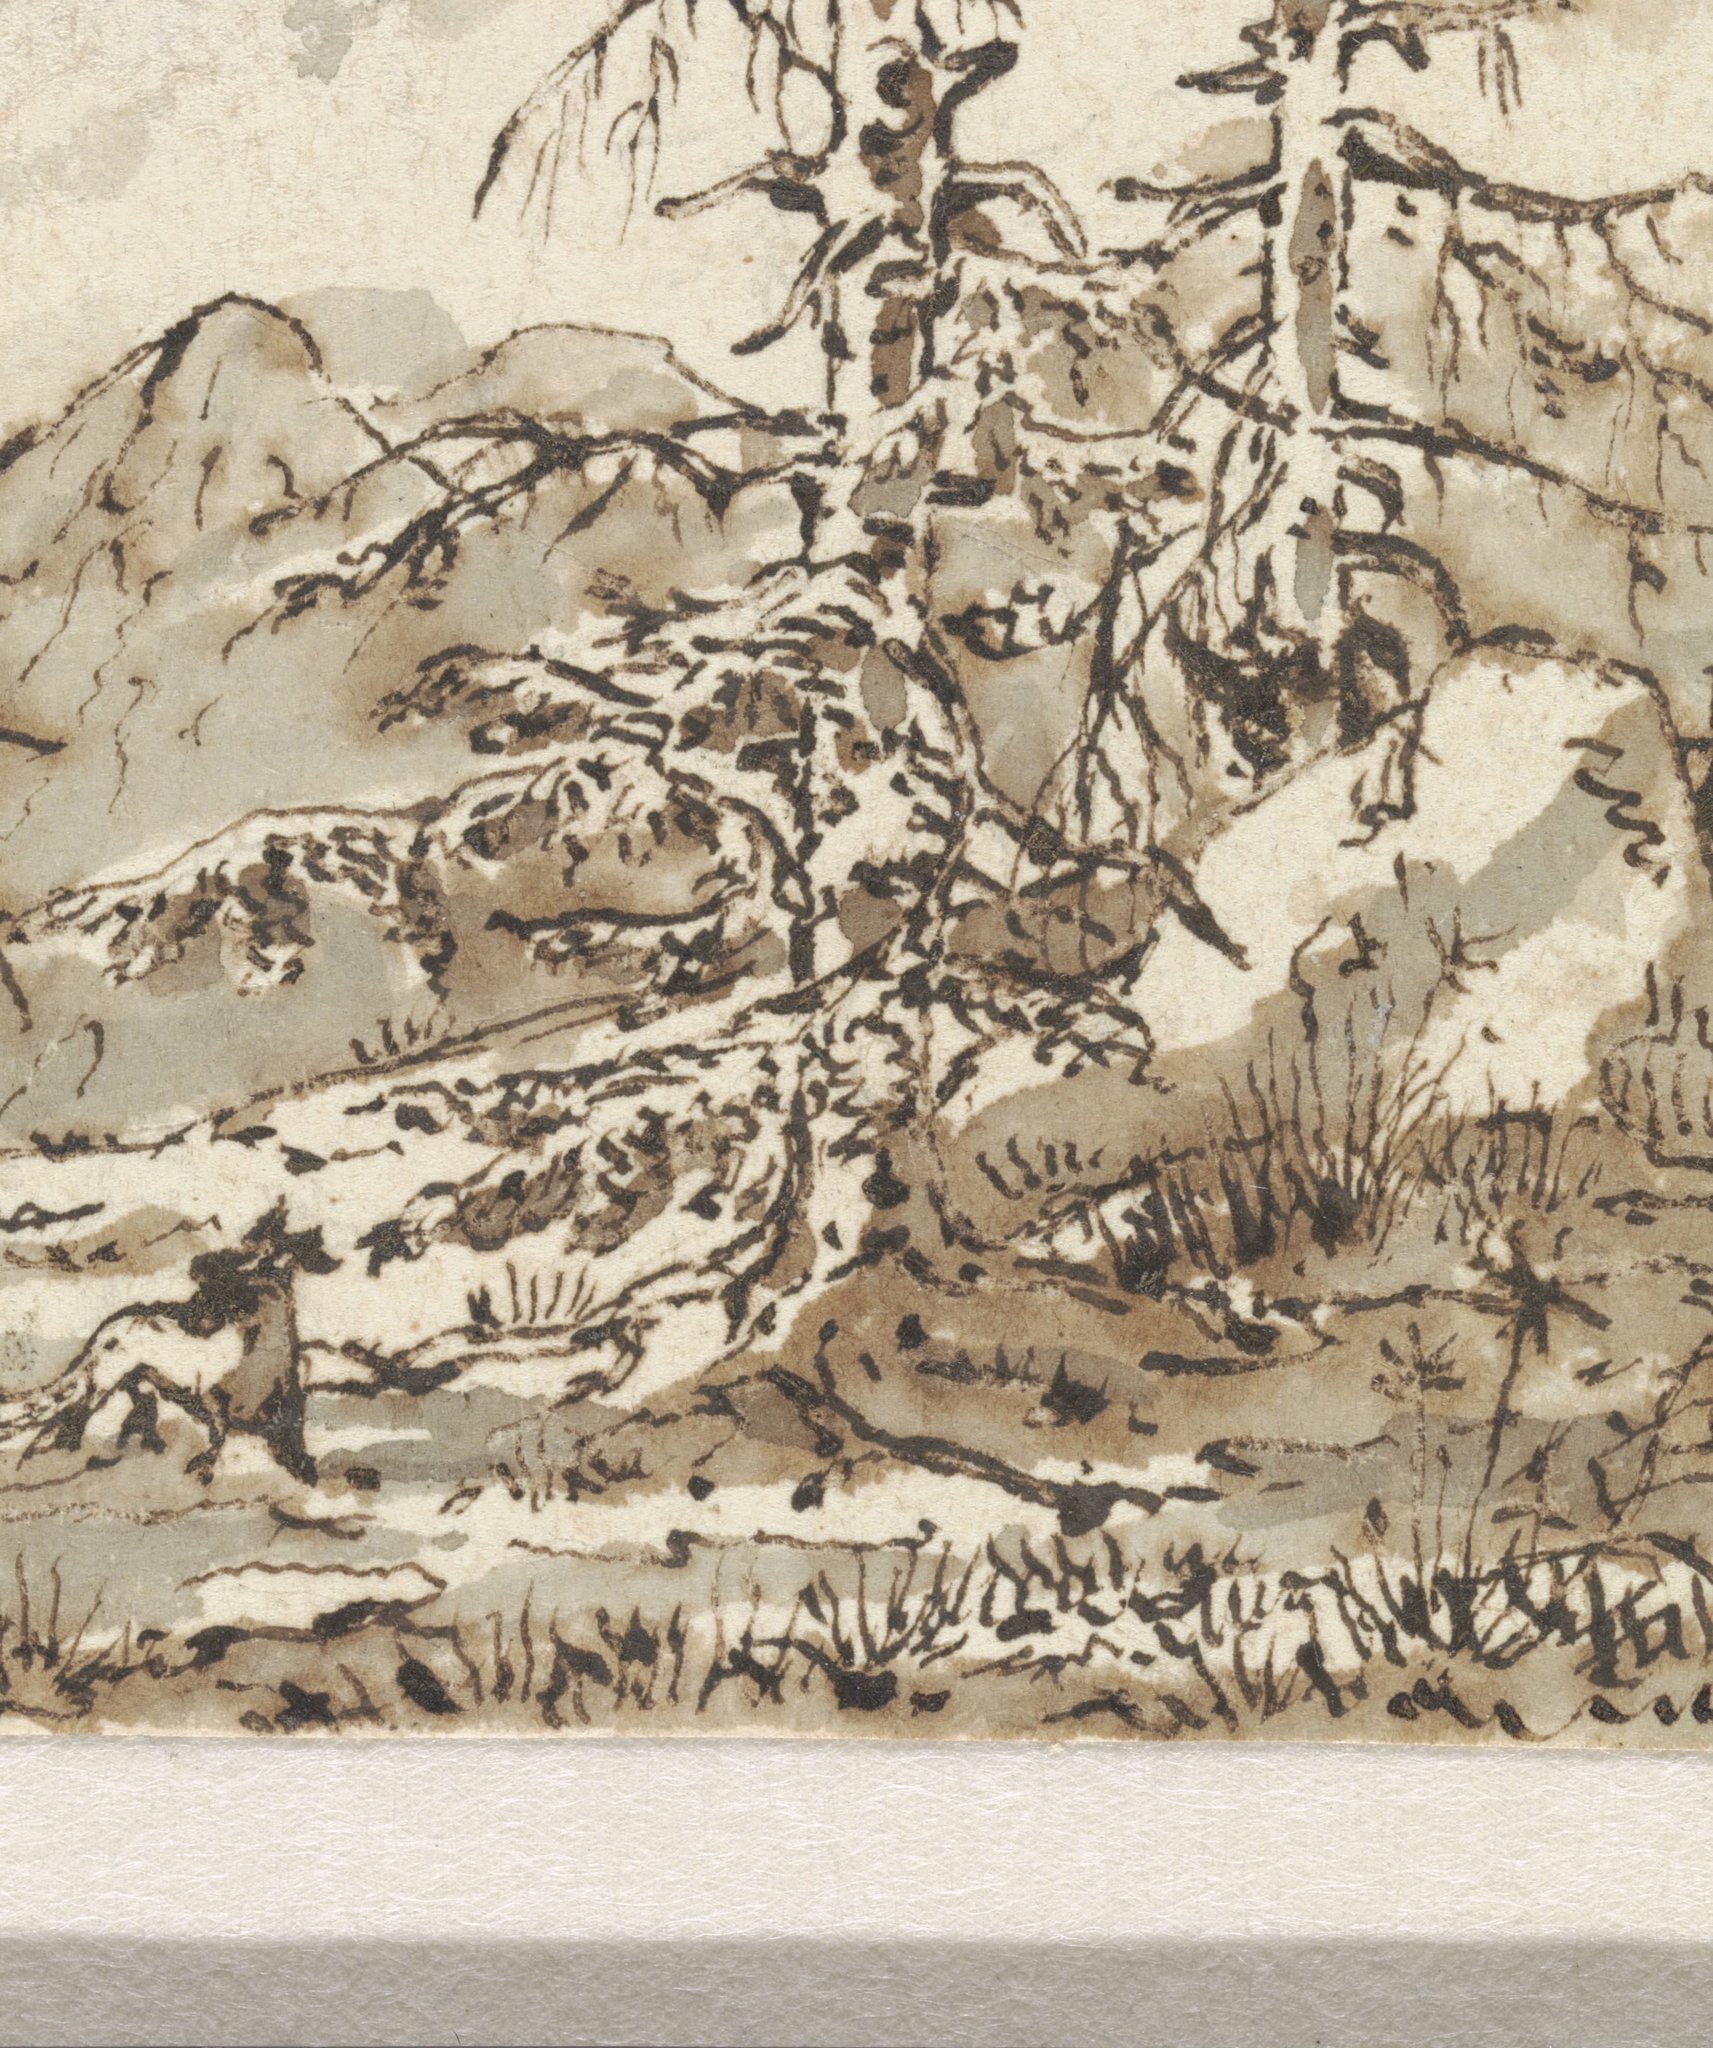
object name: drawing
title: De twee sparren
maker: gerardus emaus de micault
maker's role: draughtsman, print maker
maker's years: 1798-1863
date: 1799-1863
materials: chalk, ink, paper, pencil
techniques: brush, pen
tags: hunting, chase, trees: spruce